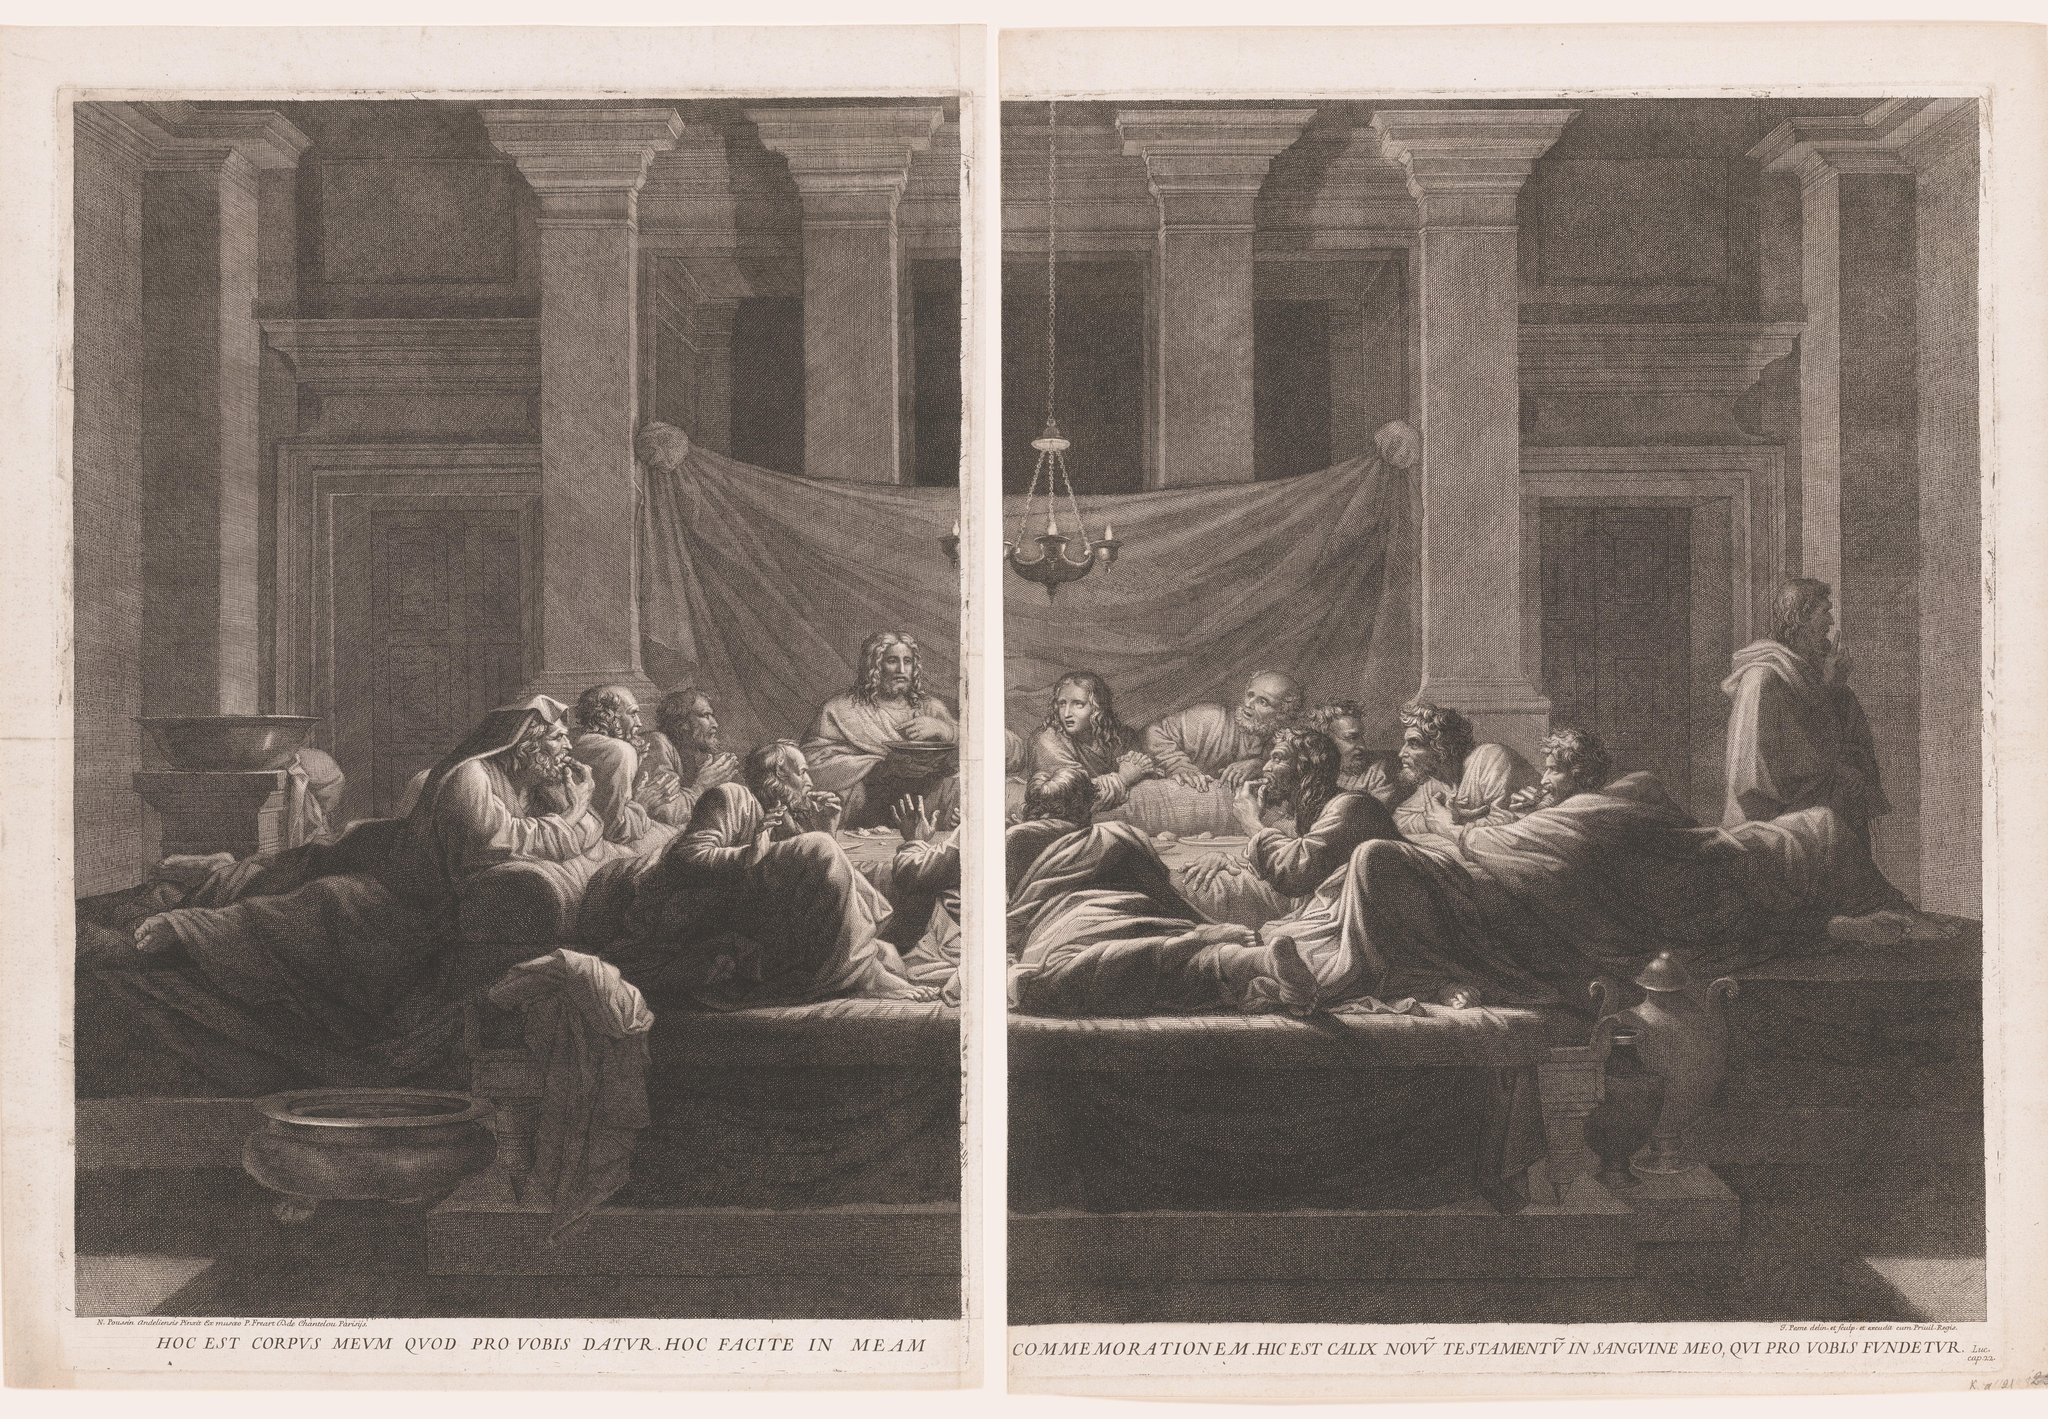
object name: print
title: Zeven sacramenten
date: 1633-1700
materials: paper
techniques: etching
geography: france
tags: the eucharist ~ the fourth of the seven sacraments, institution of the eucharist, i.e. christ showing or blessing bread (host) and/or wine (matthew 26:26-27; mark 14:22-23; luke 22:19-20; john 13:26; 1 corinthians 11:23-25)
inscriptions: collector's mark: Lugt 240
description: Prent maakt deel uit van een ongenummerde serie van zeven prenten. Dit object is omwille van een betere presentatie virtueel samengevoegd, maar bestaat fysiek uit losse onderdelen.